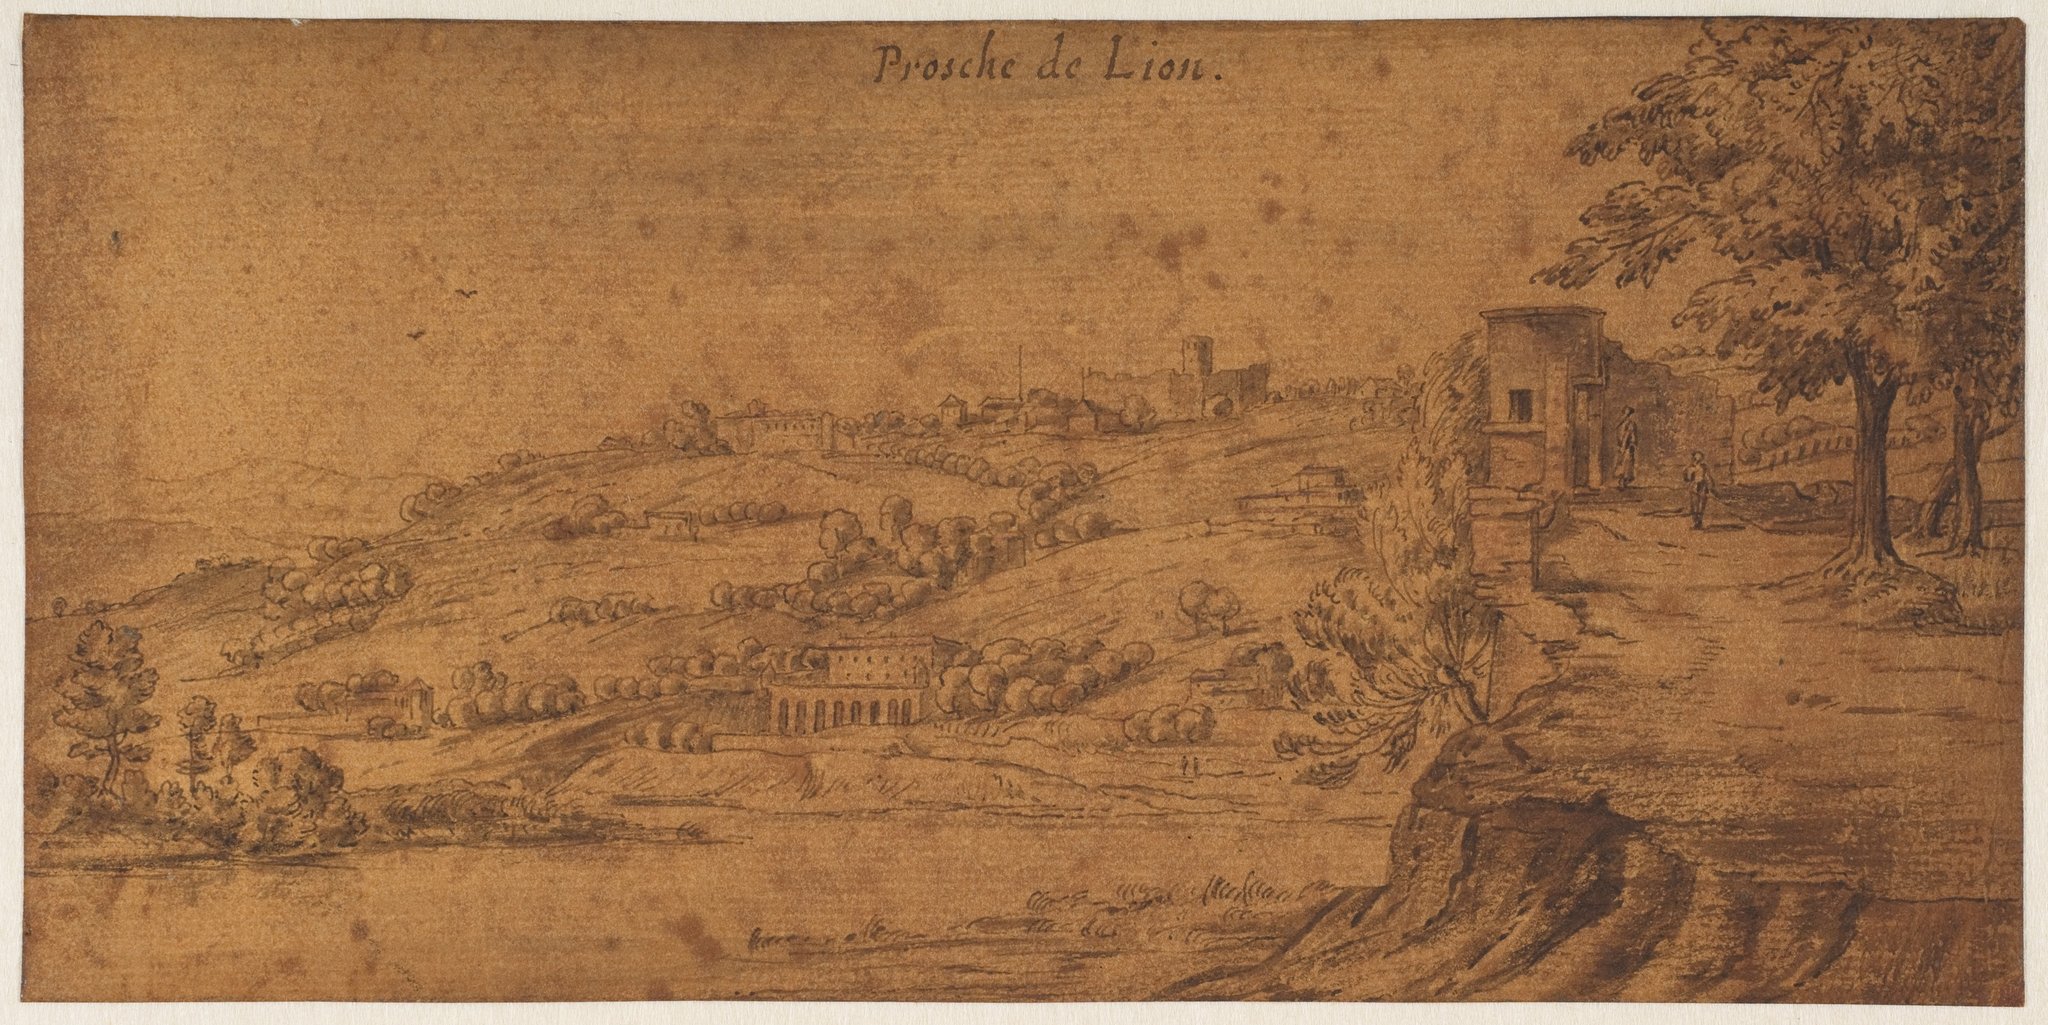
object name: drawing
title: View of the Rhone river near Saint-Genis-Laval, south of Lyons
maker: michiel van overbeek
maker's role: artist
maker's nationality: dutch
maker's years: 1663-1709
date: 1667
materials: ink, paper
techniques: pen, wash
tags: rivers,trees